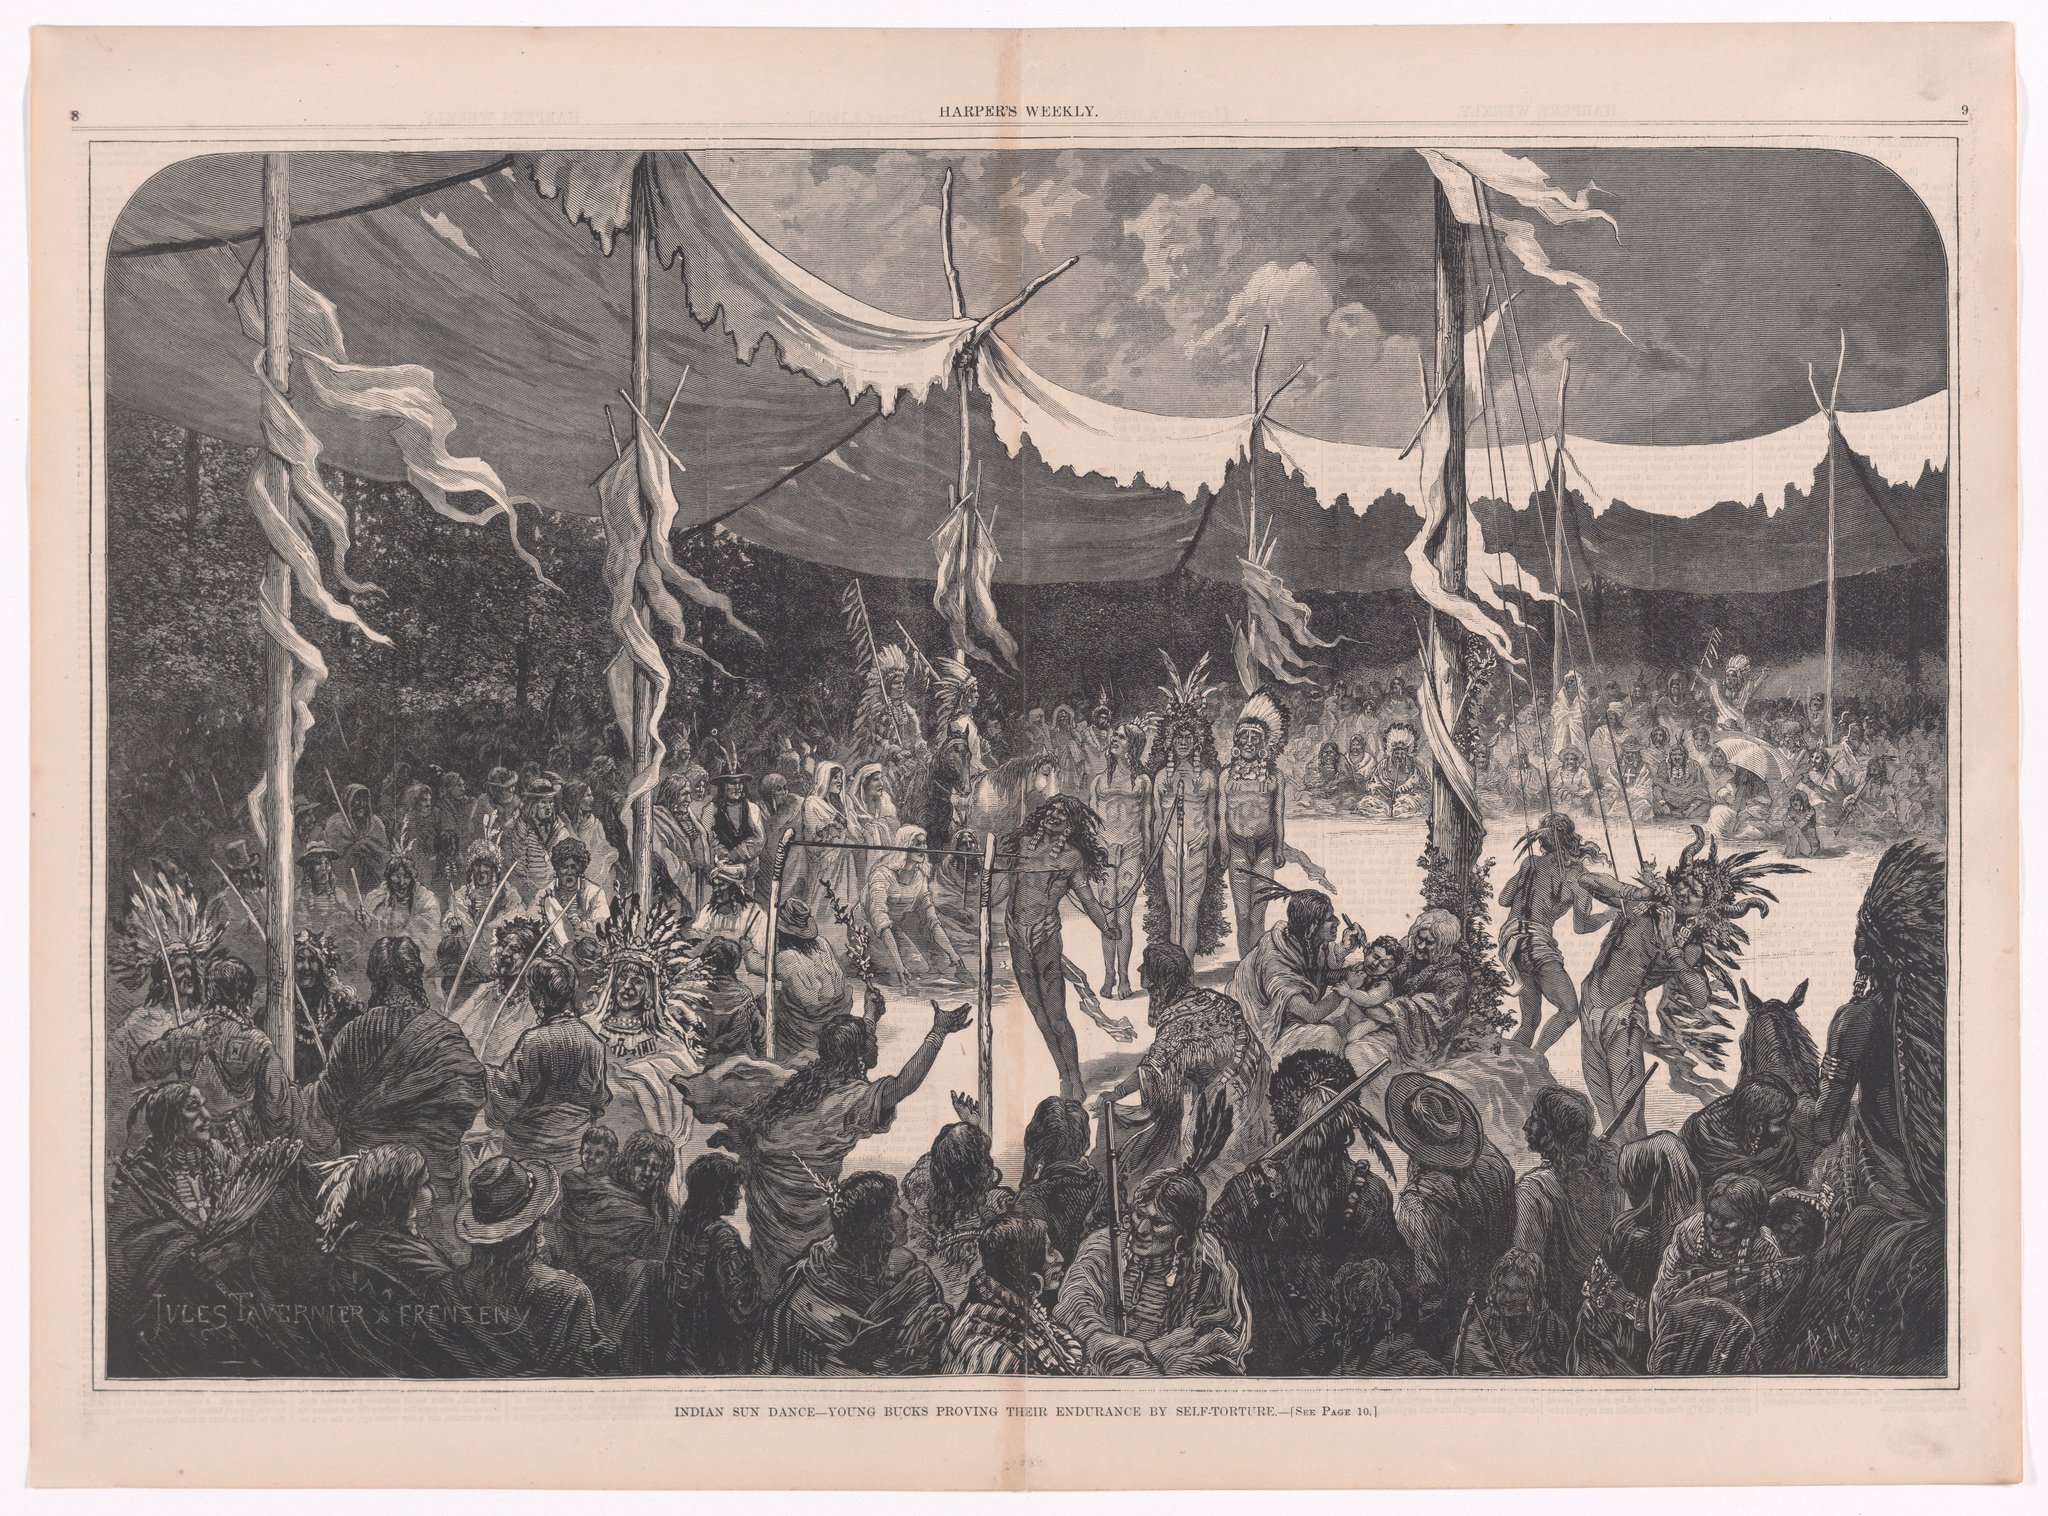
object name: print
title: Indian Sun Dance–Young Bucks Proving Their Endurance by Self-Torture ("Harper's Weekly," Vol. XIX, pp. 8-9)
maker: jules tavernier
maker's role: artist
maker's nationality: american, born france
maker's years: 1844-1889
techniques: engraving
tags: ceremony